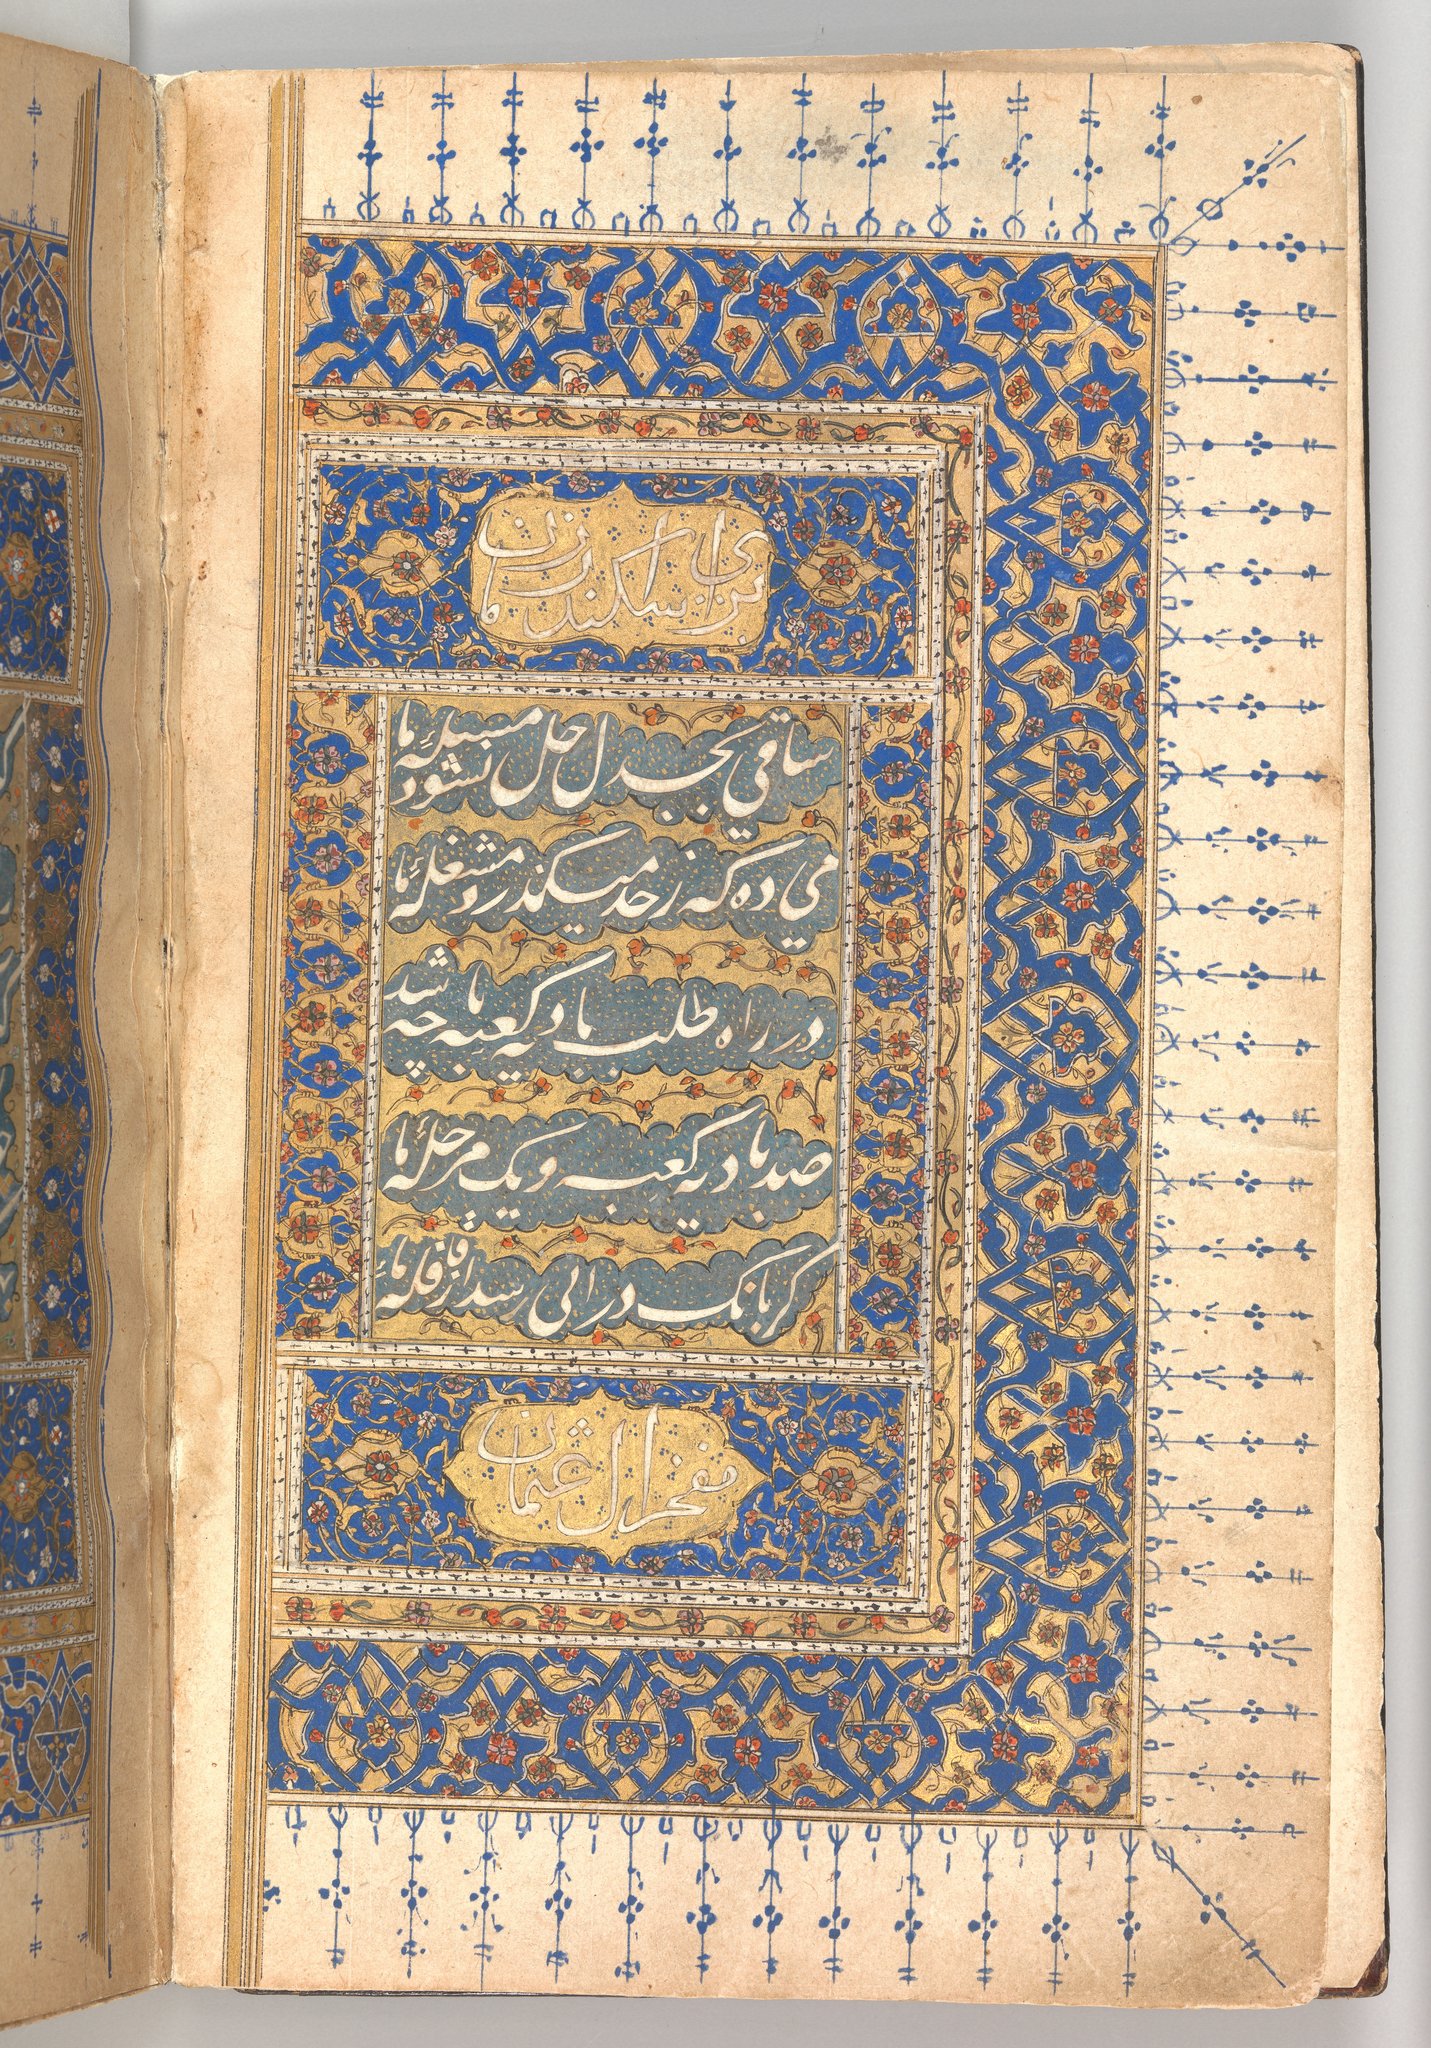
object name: section from a non illustrated manuscript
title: Anthology of Persian Poetry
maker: amir shahi of sabzavar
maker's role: poet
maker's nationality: iranian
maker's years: -1453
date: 1501-1600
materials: gold, ink, lacquer, paper, watercolor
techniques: bookbinding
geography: turkey or iran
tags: poetry